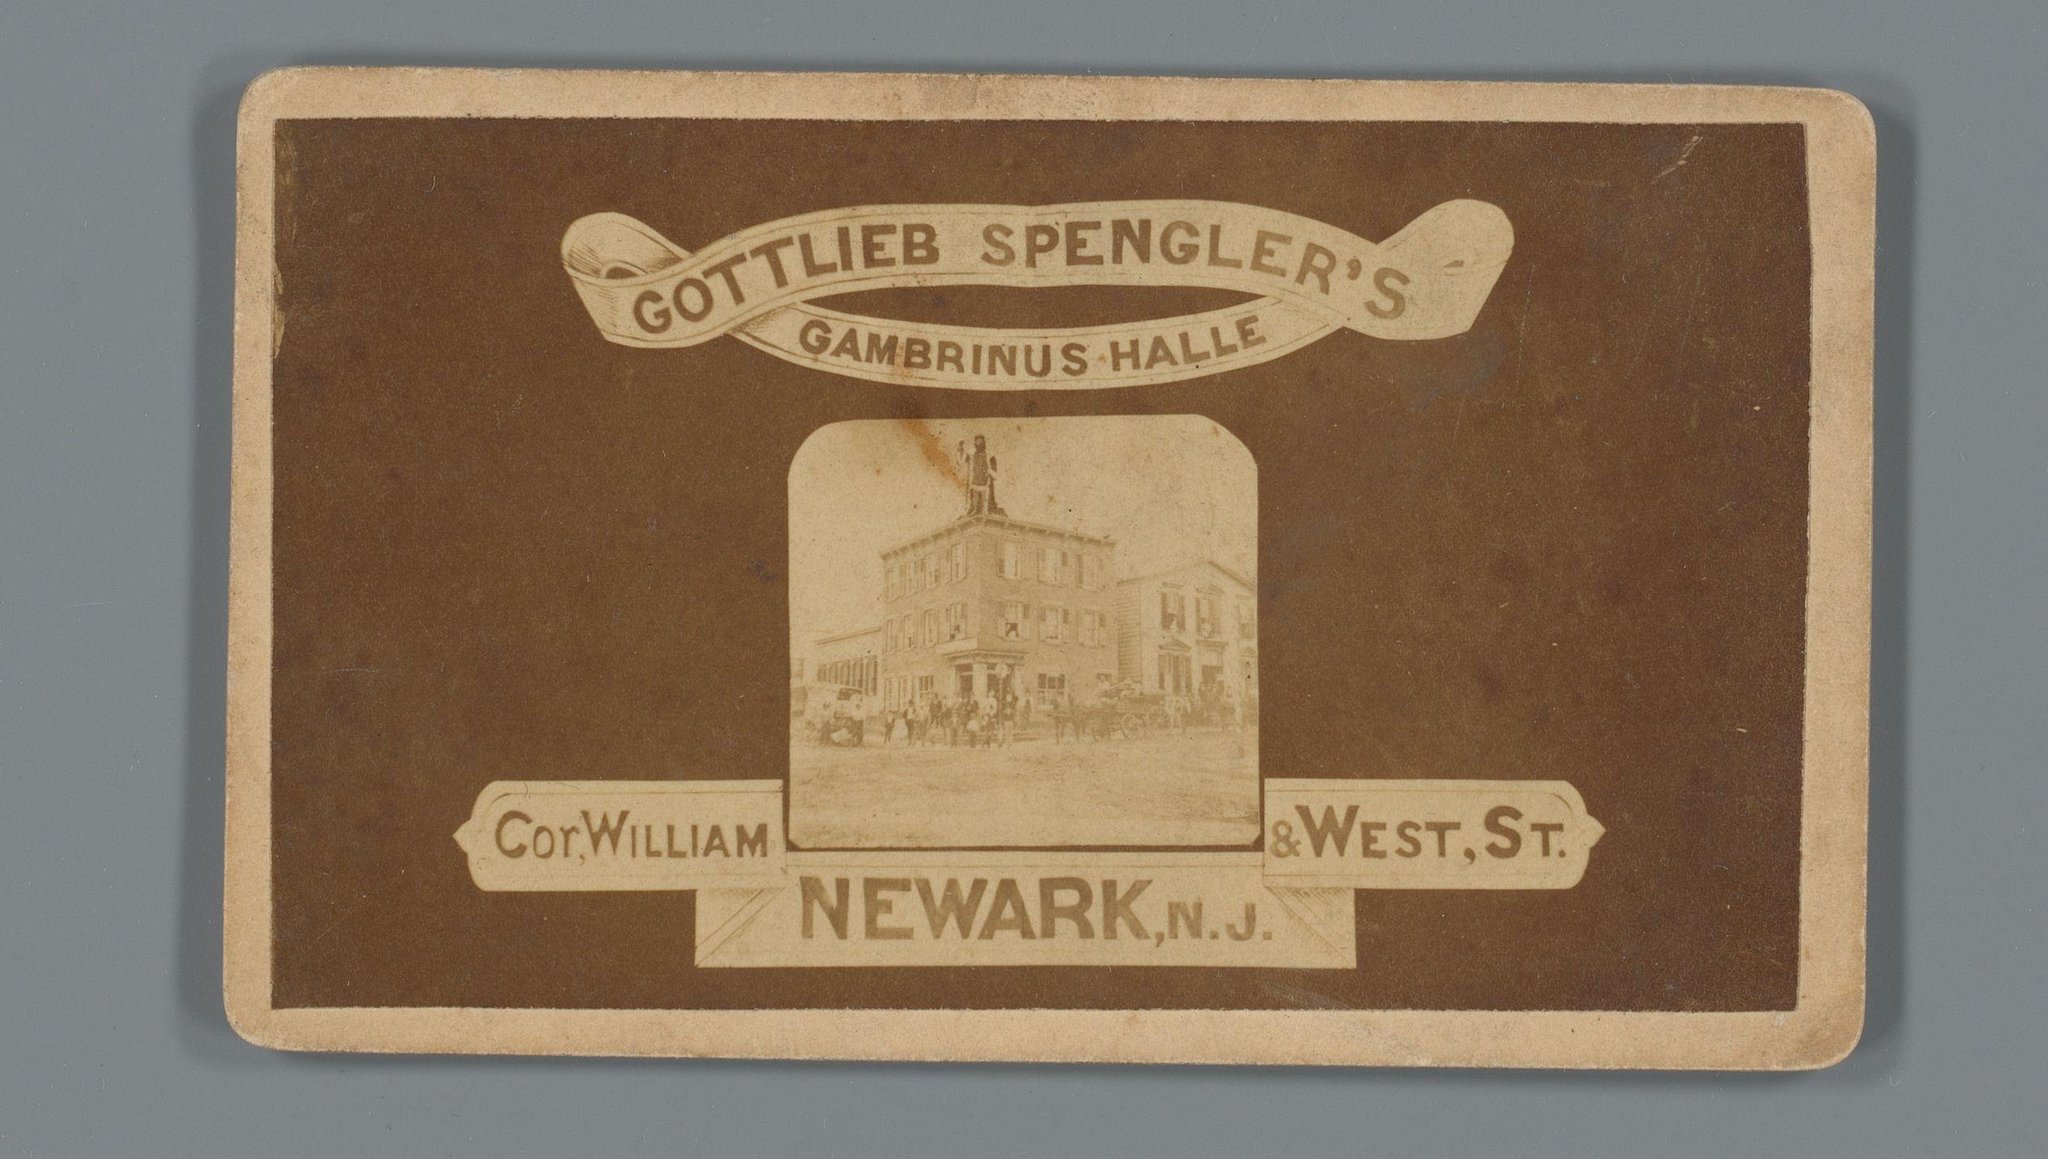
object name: carte de visite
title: Gezicht op een hoekpand in Newark als reclame voor Gottlieb Spengler's Gambrinus Halle, New Jersey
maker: Anonymous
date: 1850-1915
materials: cardboard, photographic support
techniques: albumen print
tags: advertising, civic architecture; edifices; dwellings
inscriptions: inscription: ‘Kazenmayer./ Cor. Springfield Avenue & Broome Street,/ NEWARK, N.J.’, inscription: ‘GOTTLIEB SPENGLER'S/ GAMBRINUS HALLE/ Cor. WILLIAM & WEST St./ NEWARK, N.J.’